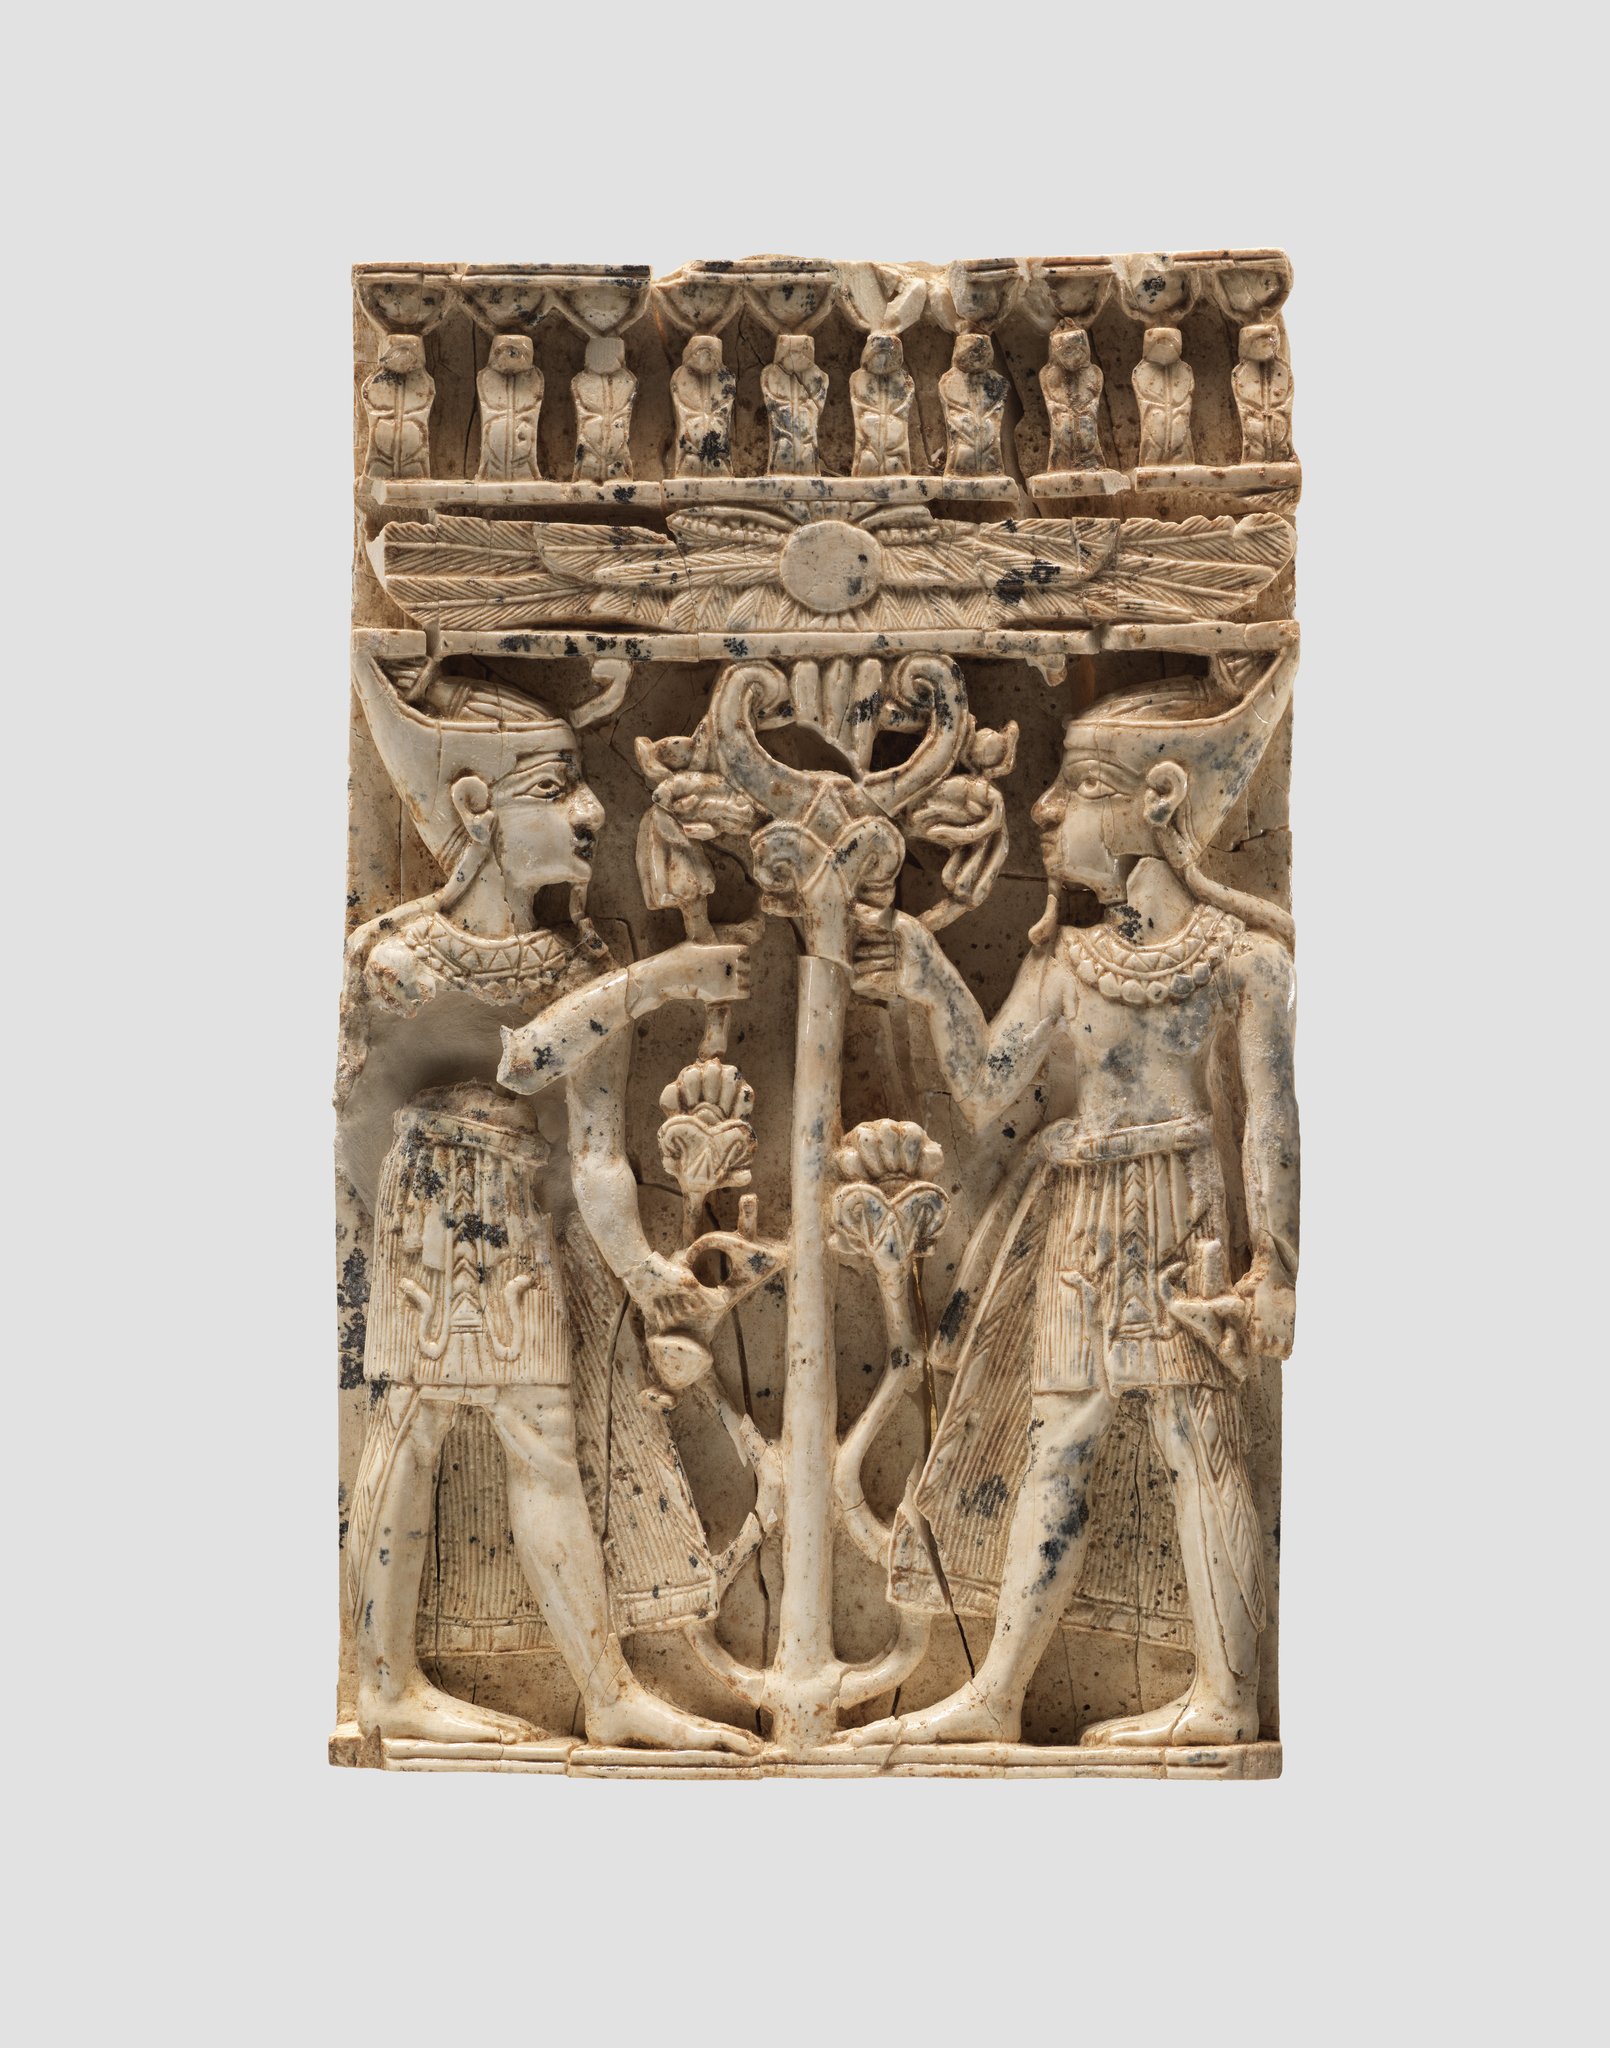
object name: relief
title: Furniture plaque carved in high relief with two Egyptianizing figures flanking a volute tree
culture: assyrian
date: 900-701 BCE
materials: ivory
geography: mesopotamia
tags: men,trees